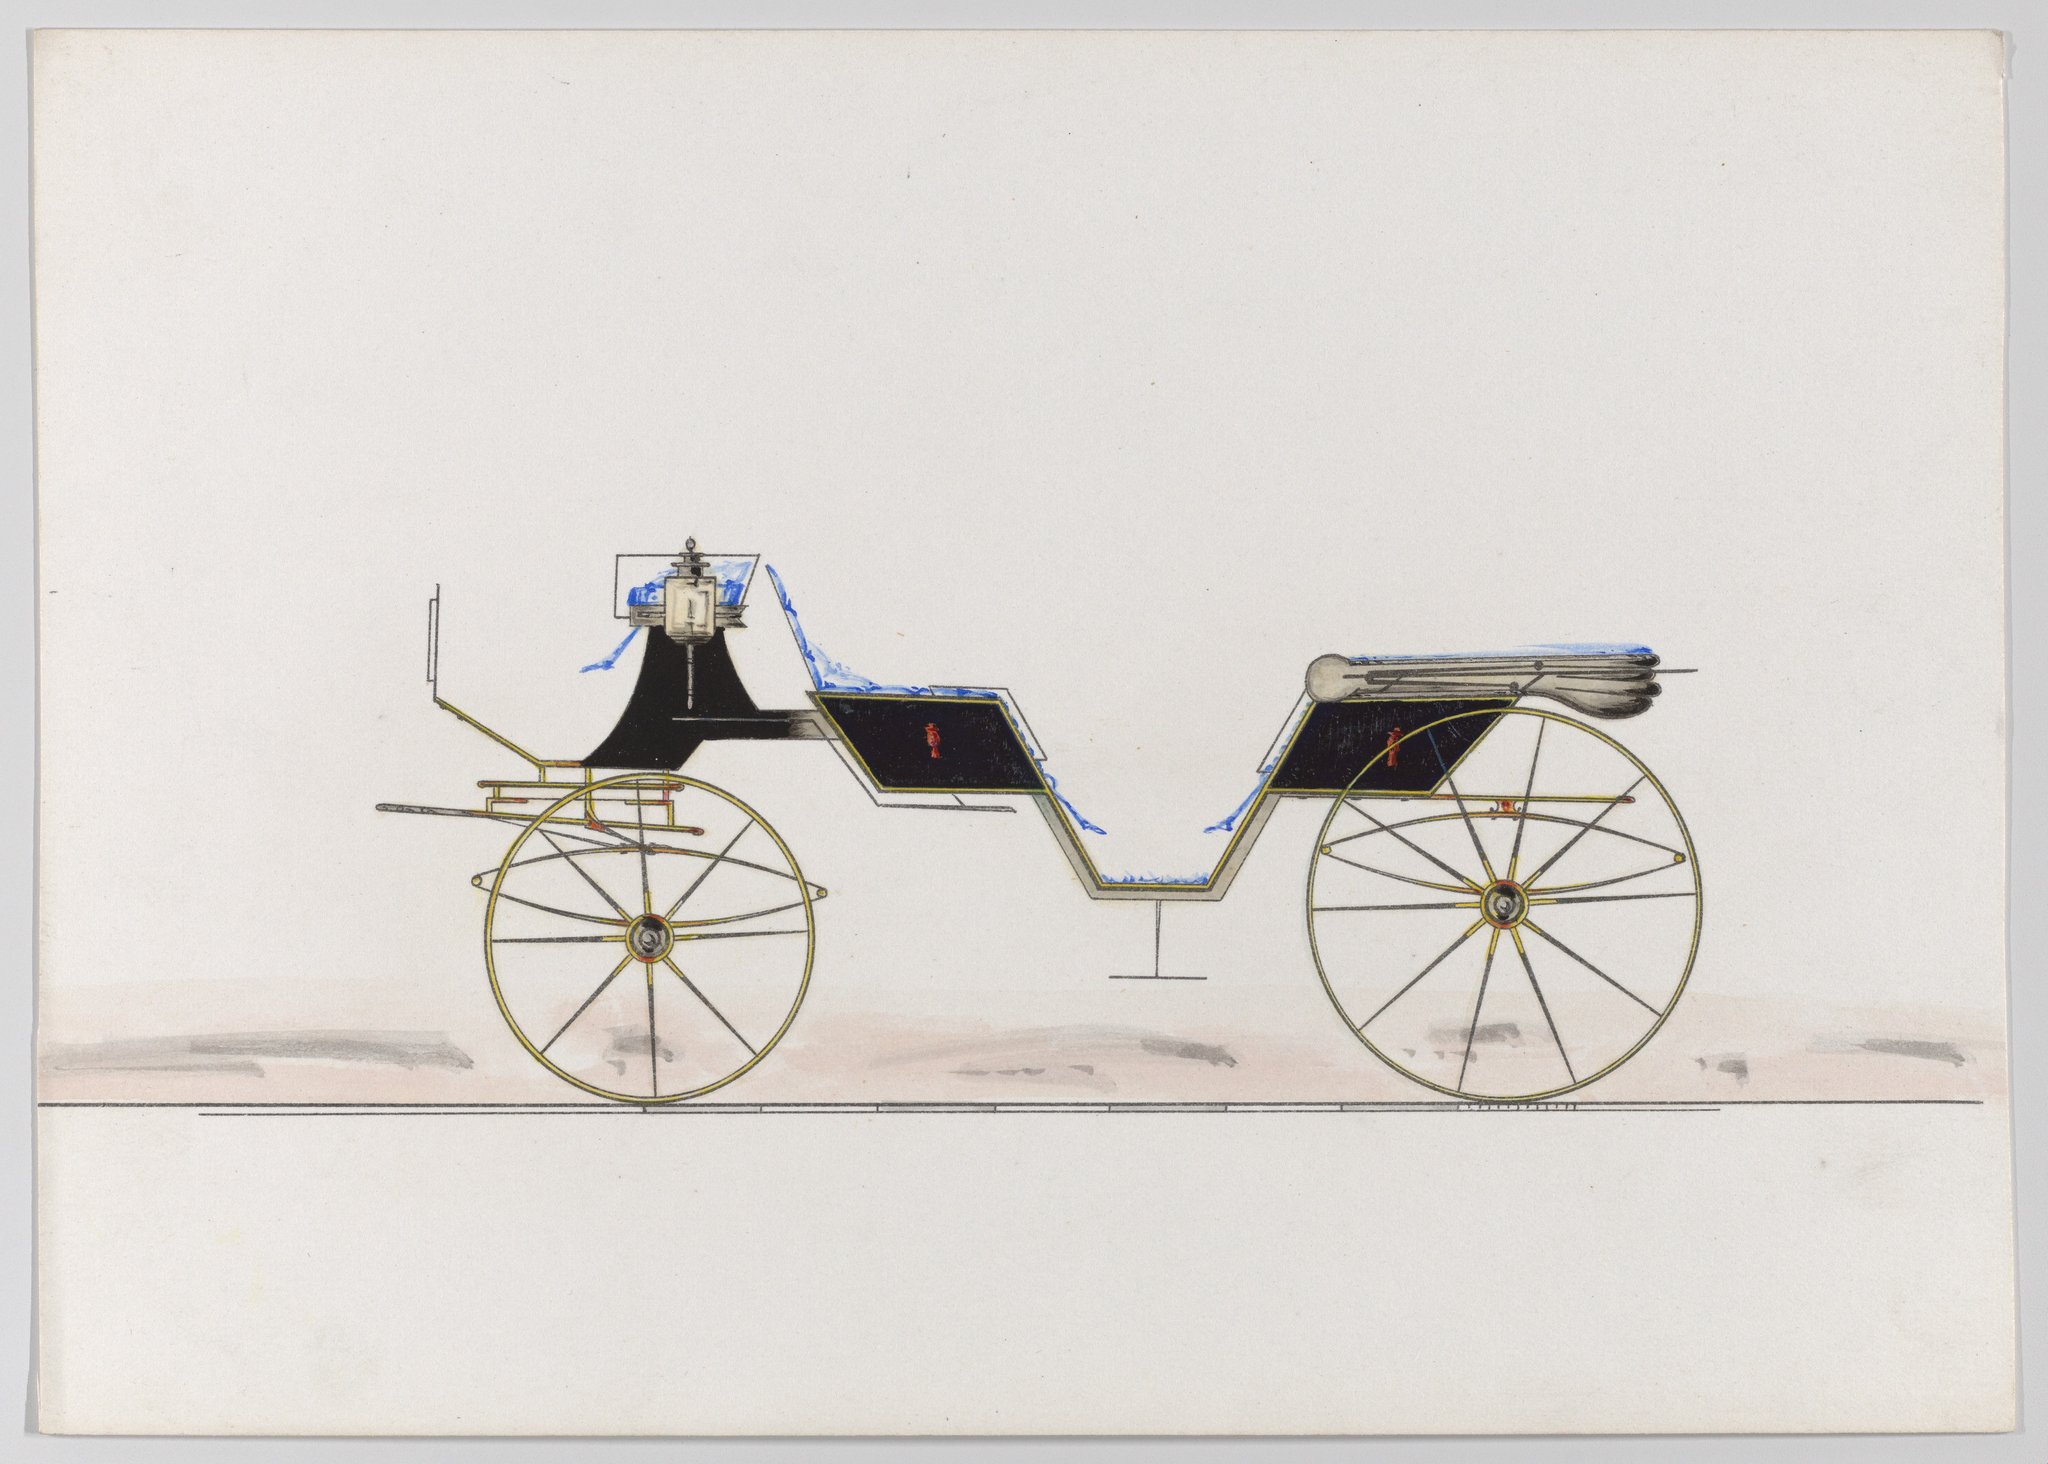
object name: drawing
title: Design for Vis-à-vis (unnumbered)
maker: brewster & co.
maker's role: manufacturer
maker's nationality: american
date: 1875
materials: gouache, gum arabic, ink, watercolor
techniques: pen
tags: carriages